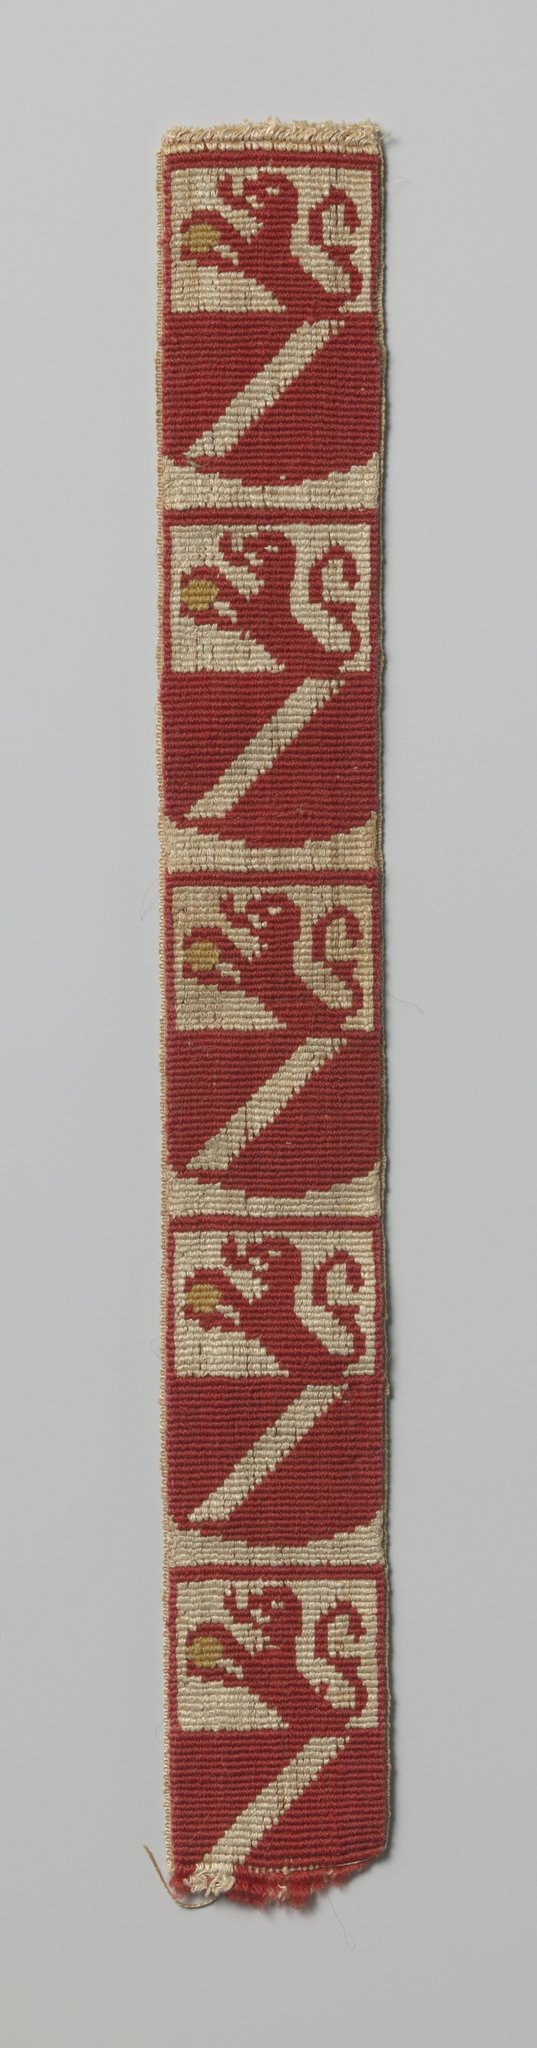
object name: passementerie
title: Livreiband met wapen familie Backer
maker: Anonymous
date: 1750-1799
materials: silk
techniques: embroidered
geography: haarlem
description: Livreiband met wapen familie Backer van witte, rode en gele zijde met vijf maal het wapen van de Amsterdamse familie Backer. Nederland (Amsterdam of Haarlem), tweede helft 18de eeuw.